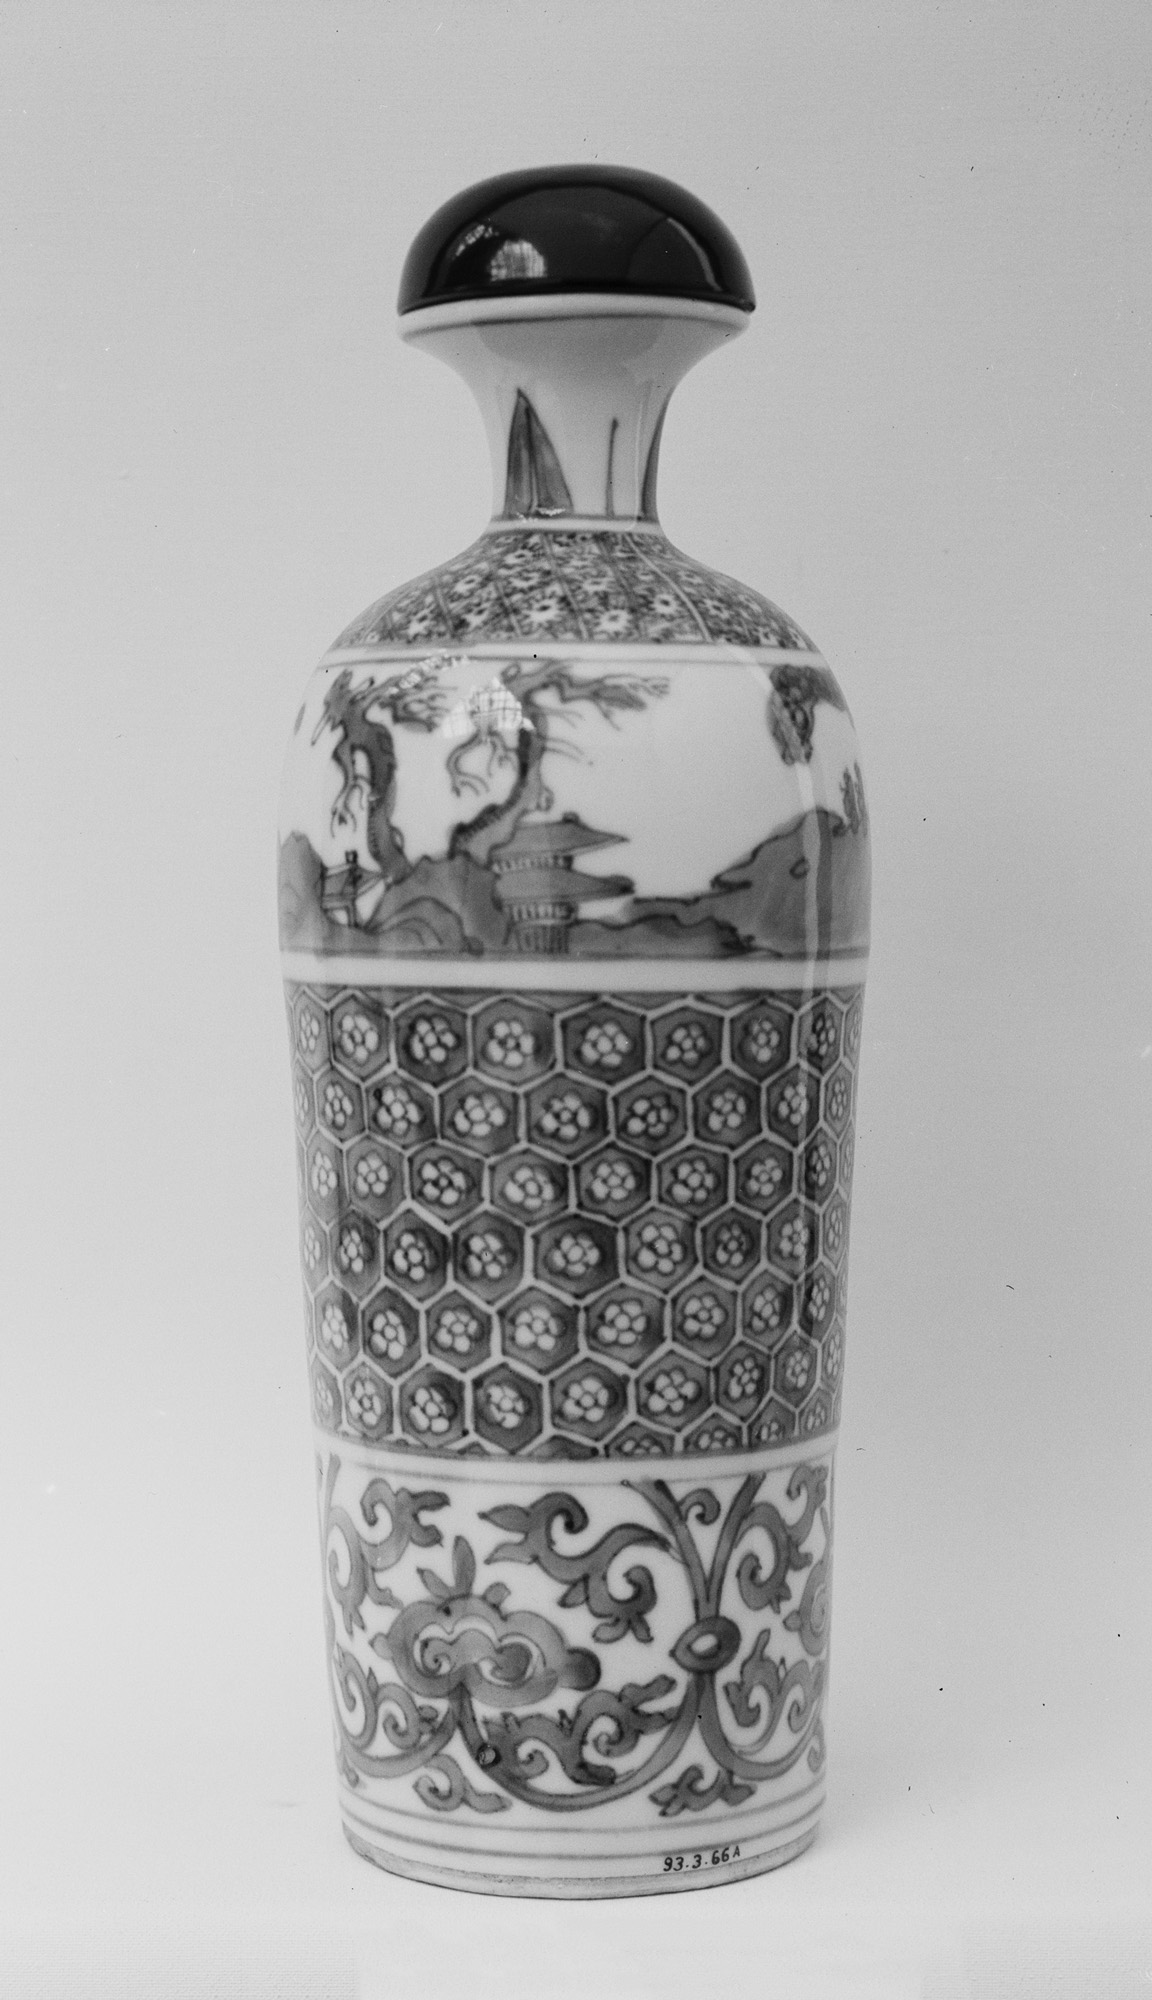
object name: bottle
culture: japanese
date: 1650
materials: glaze, lacquer, porcelain